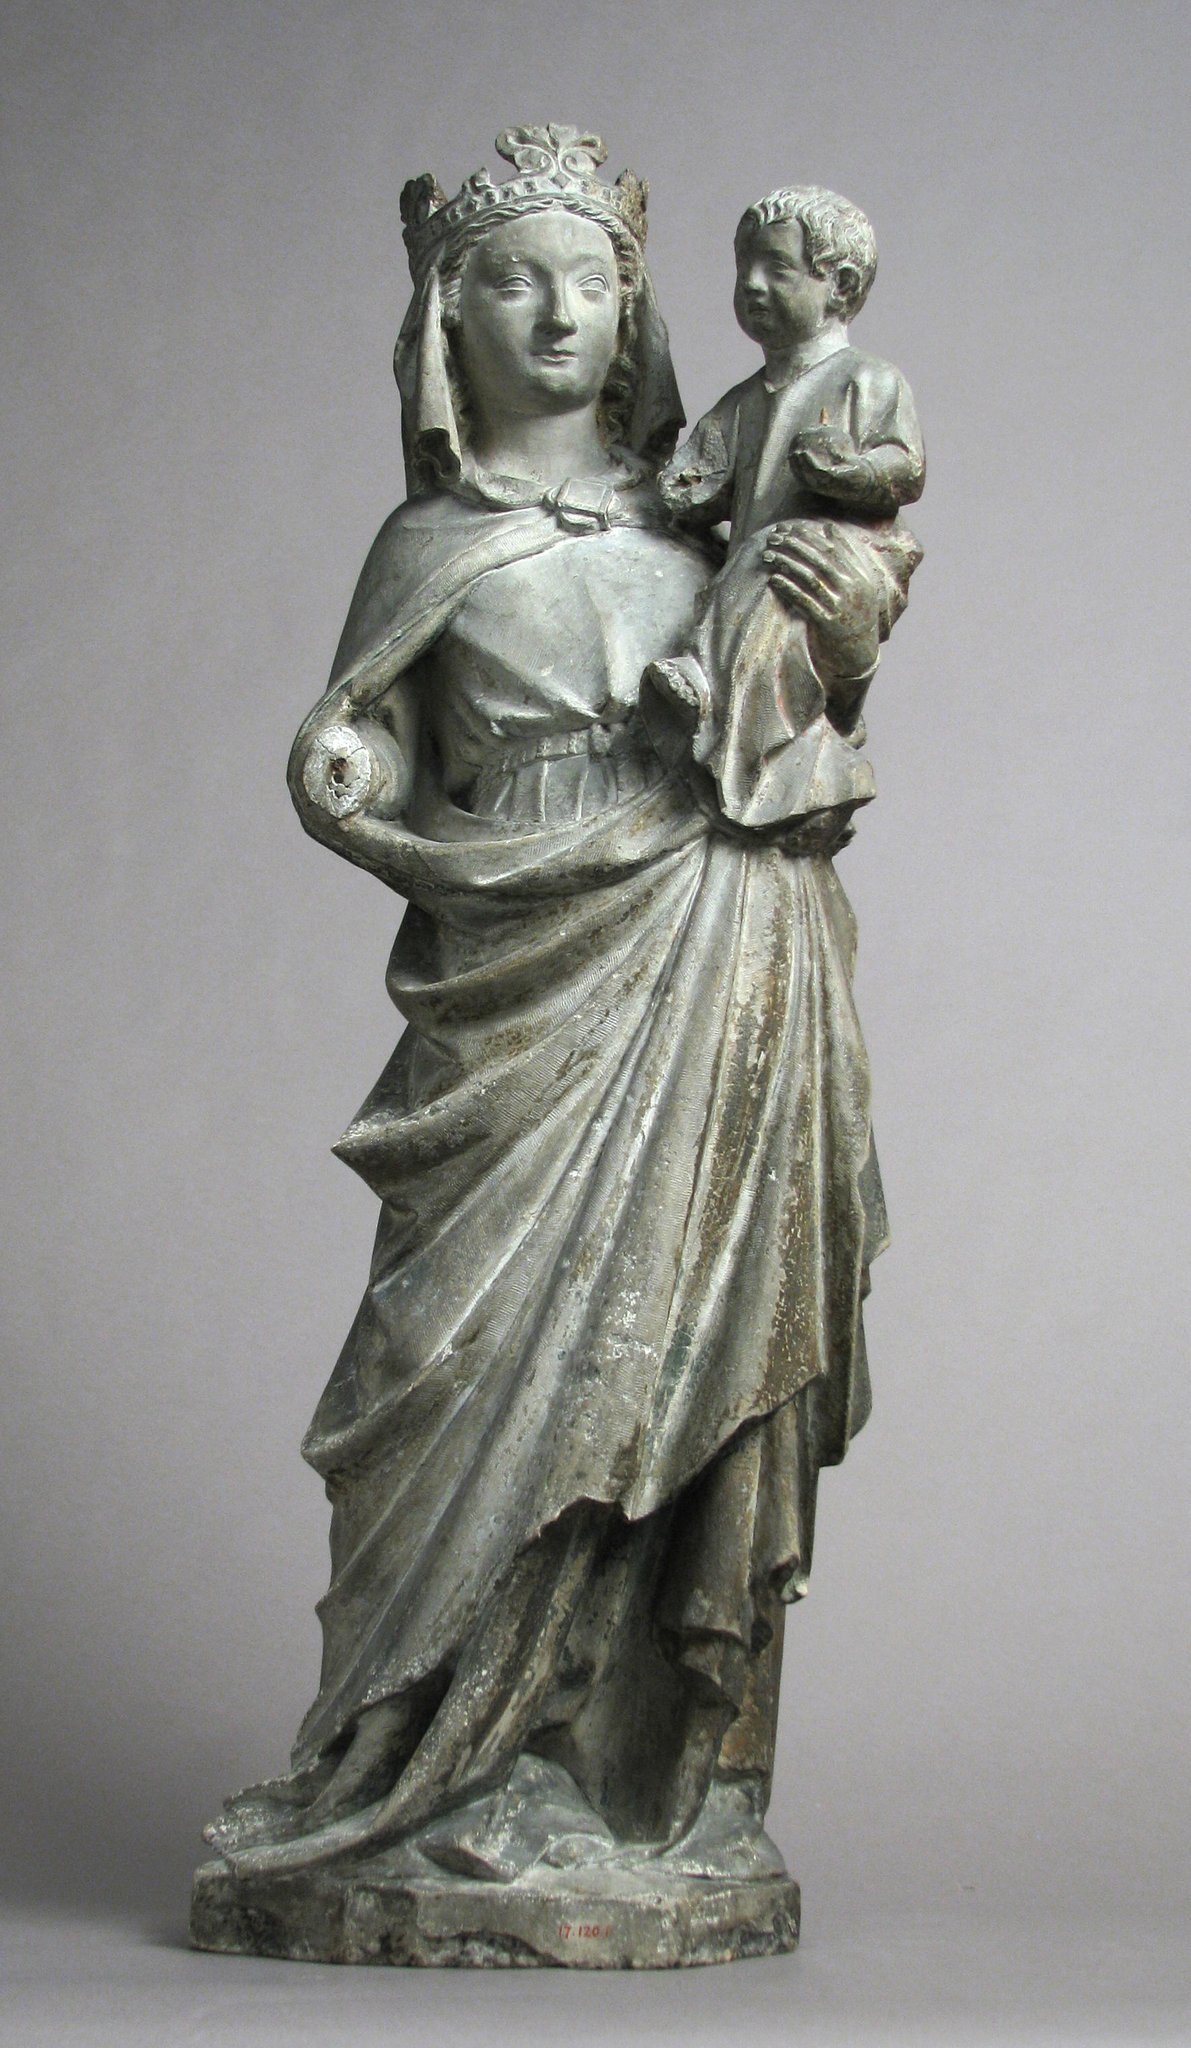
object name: statuette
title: Virgin and Child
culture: french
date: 1301-1400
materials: limestone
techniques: polychromy